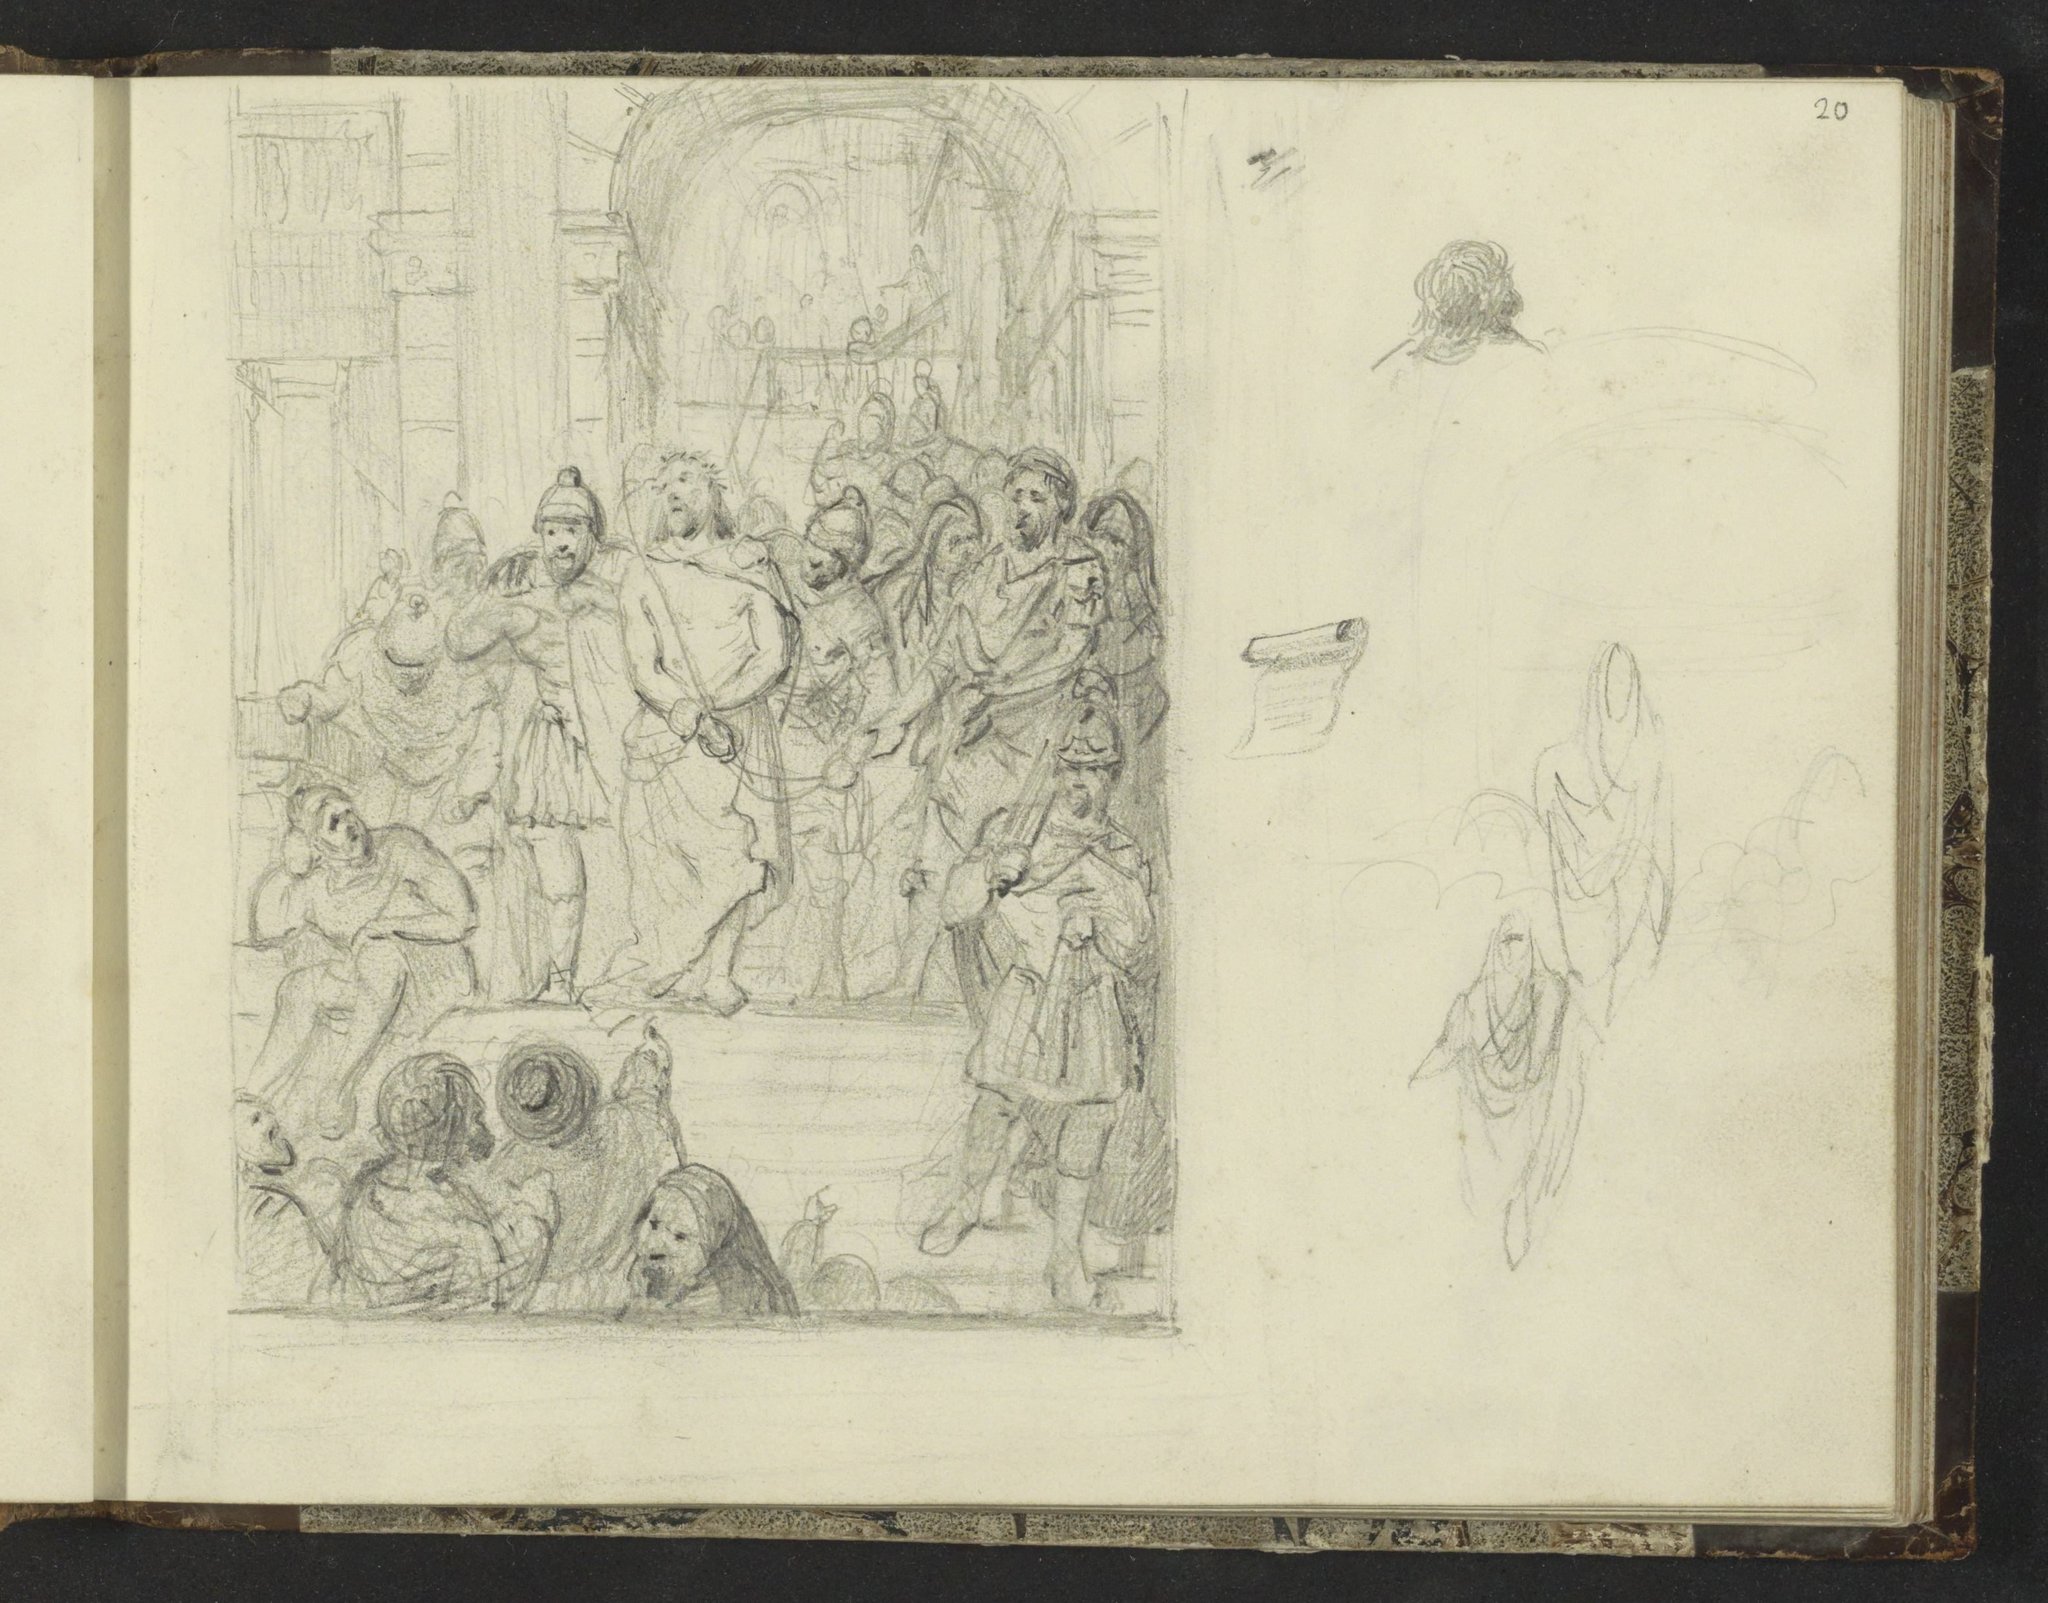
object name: sketchbook leaf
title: Christus voor Pilatus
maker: willem hendrik schmidt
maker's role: draughtsman, painter, print maker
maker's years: 1809-1849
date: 1819-1849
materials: paper, pencil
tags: pilate showing christ to the people, 'ostentatio christi', 'ecce homo' (john 19:4-6)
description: Blad 20 recto uit een schetsboek met 58 bladen.